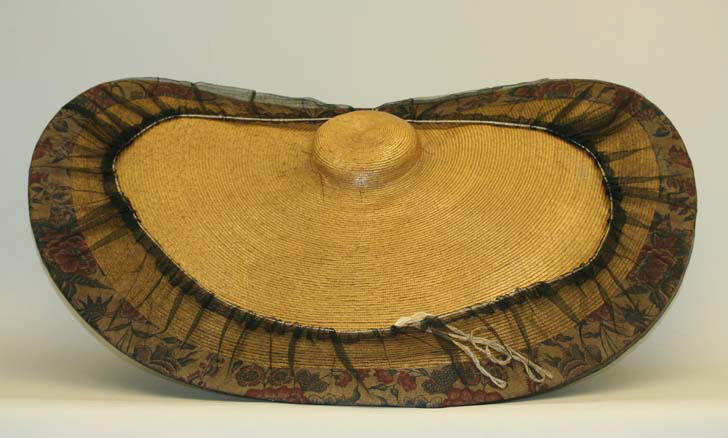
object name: hat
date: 1701-1800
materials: fiber